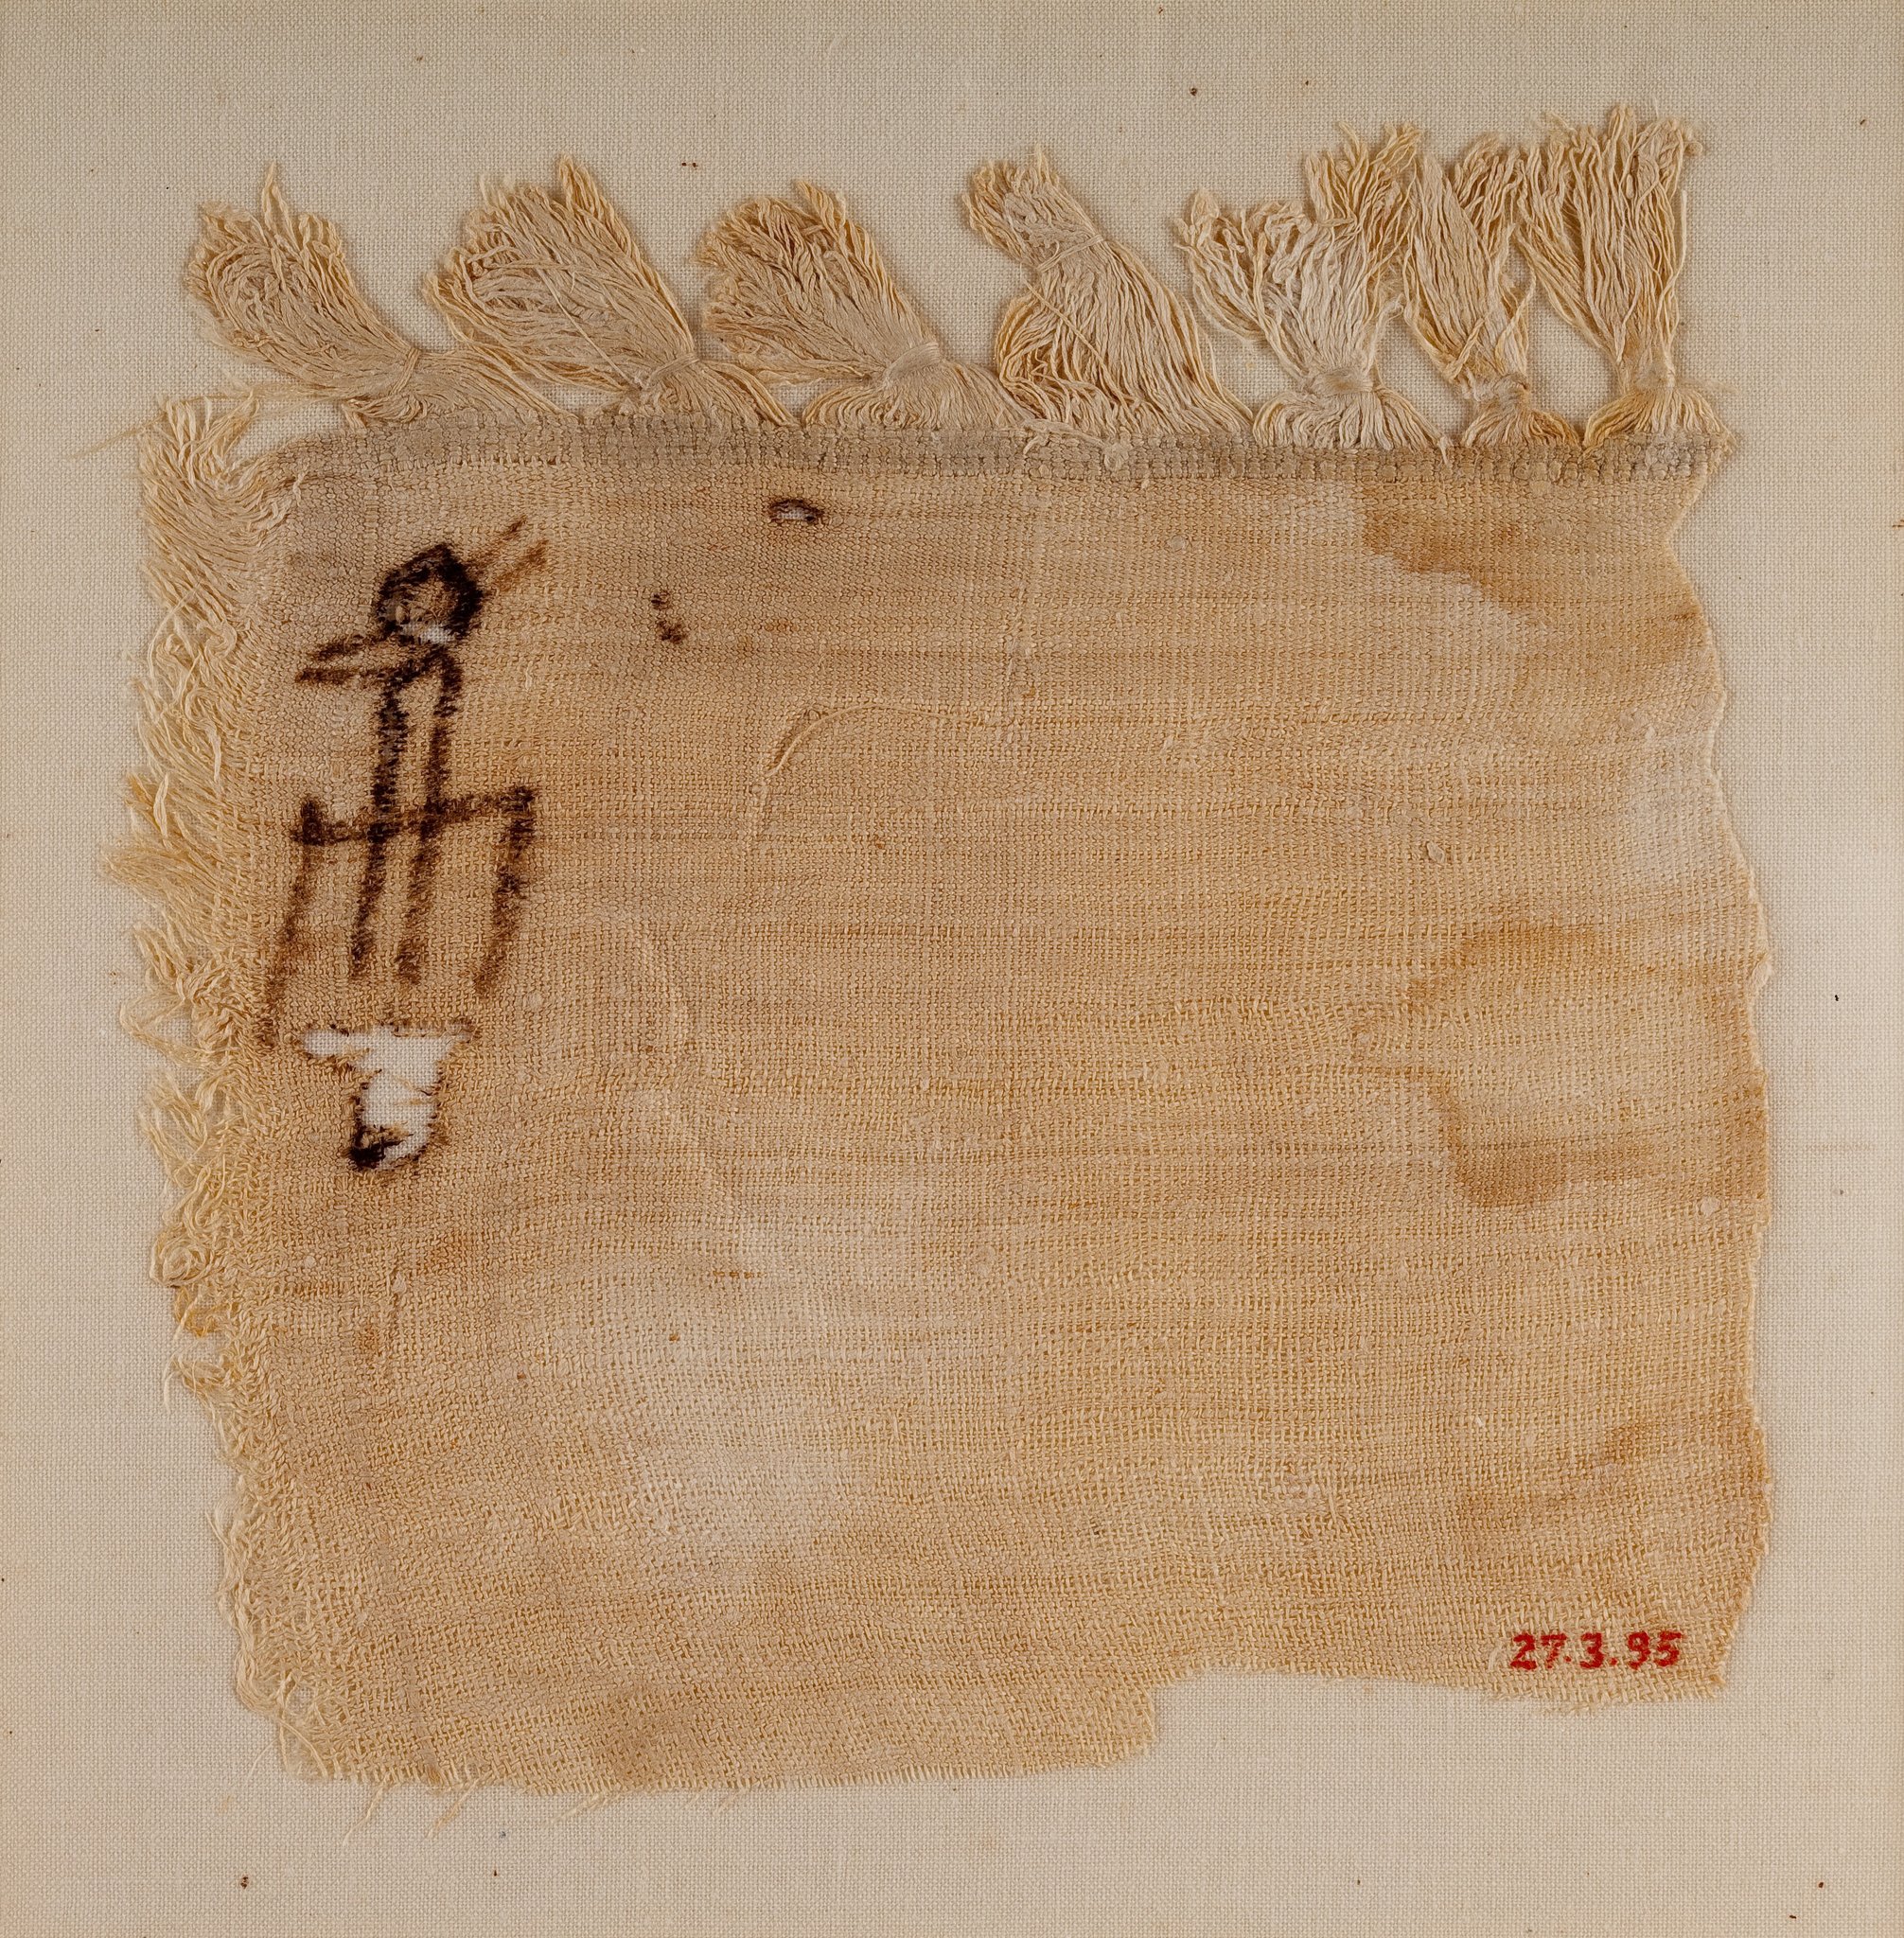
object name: linen mark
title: Linen mark (Type IV)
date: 1961-1917 BCE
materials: linen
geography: egypt